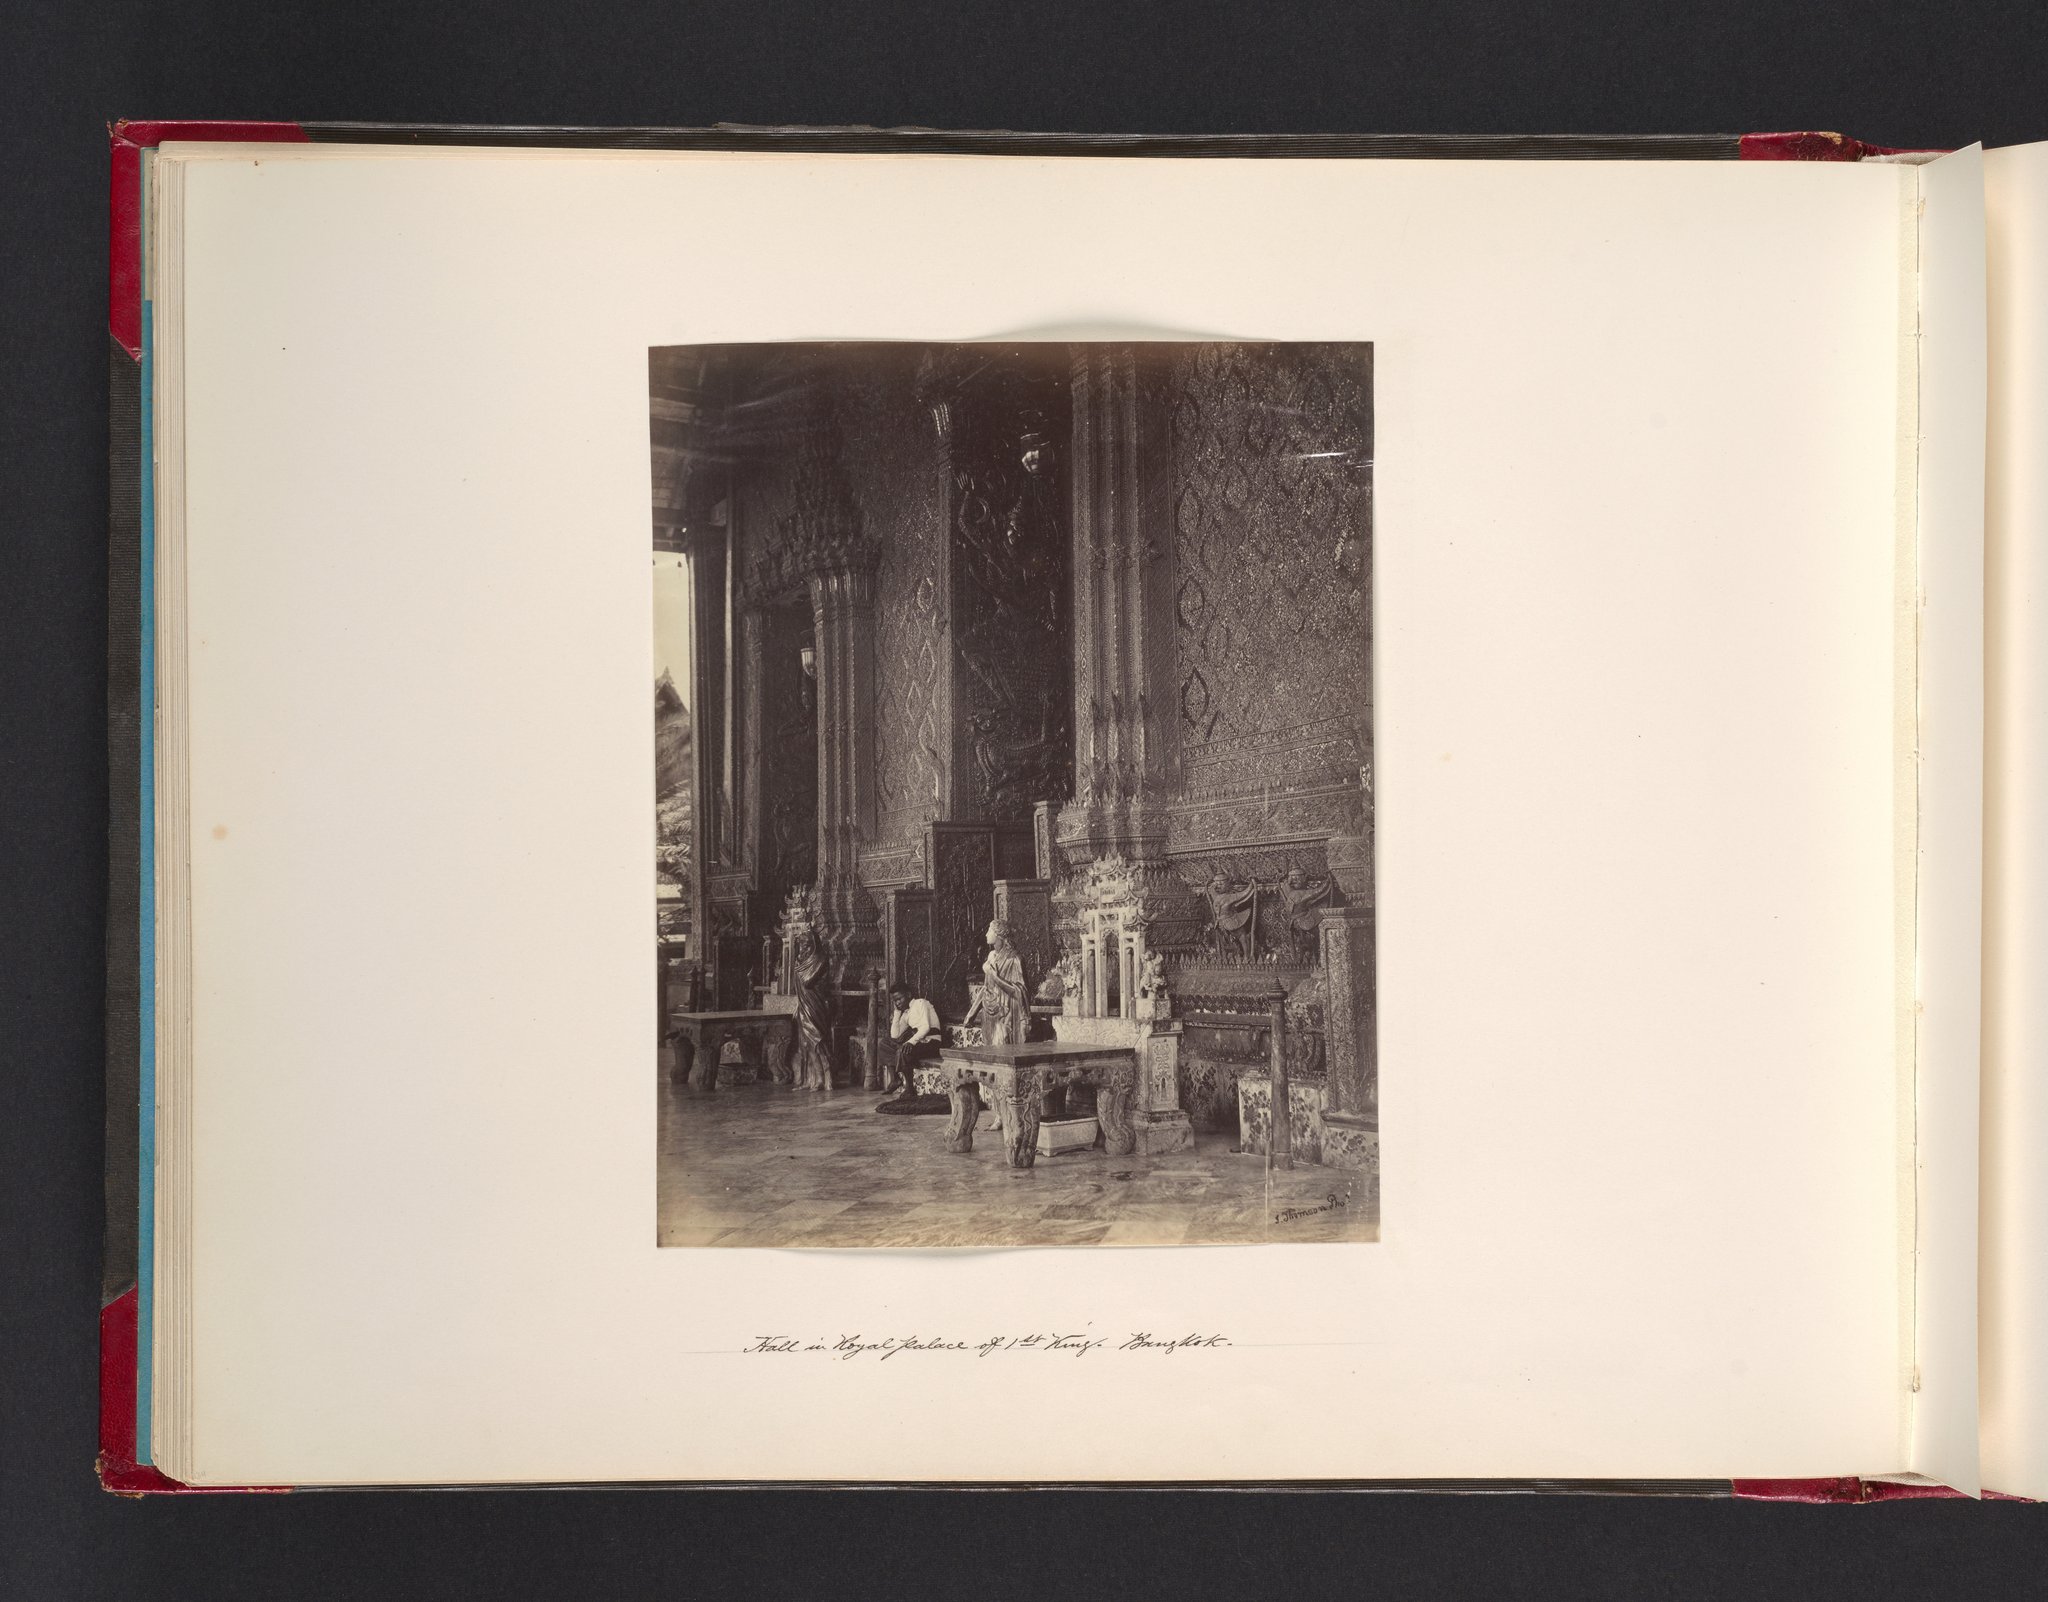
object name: photograph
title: Hall in Royal Palace of 1st King, Bangkok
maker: john thomson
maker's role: artist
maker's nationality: british, scottish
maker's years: 1837-1921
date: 1865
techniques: albumen silver print, glass negative